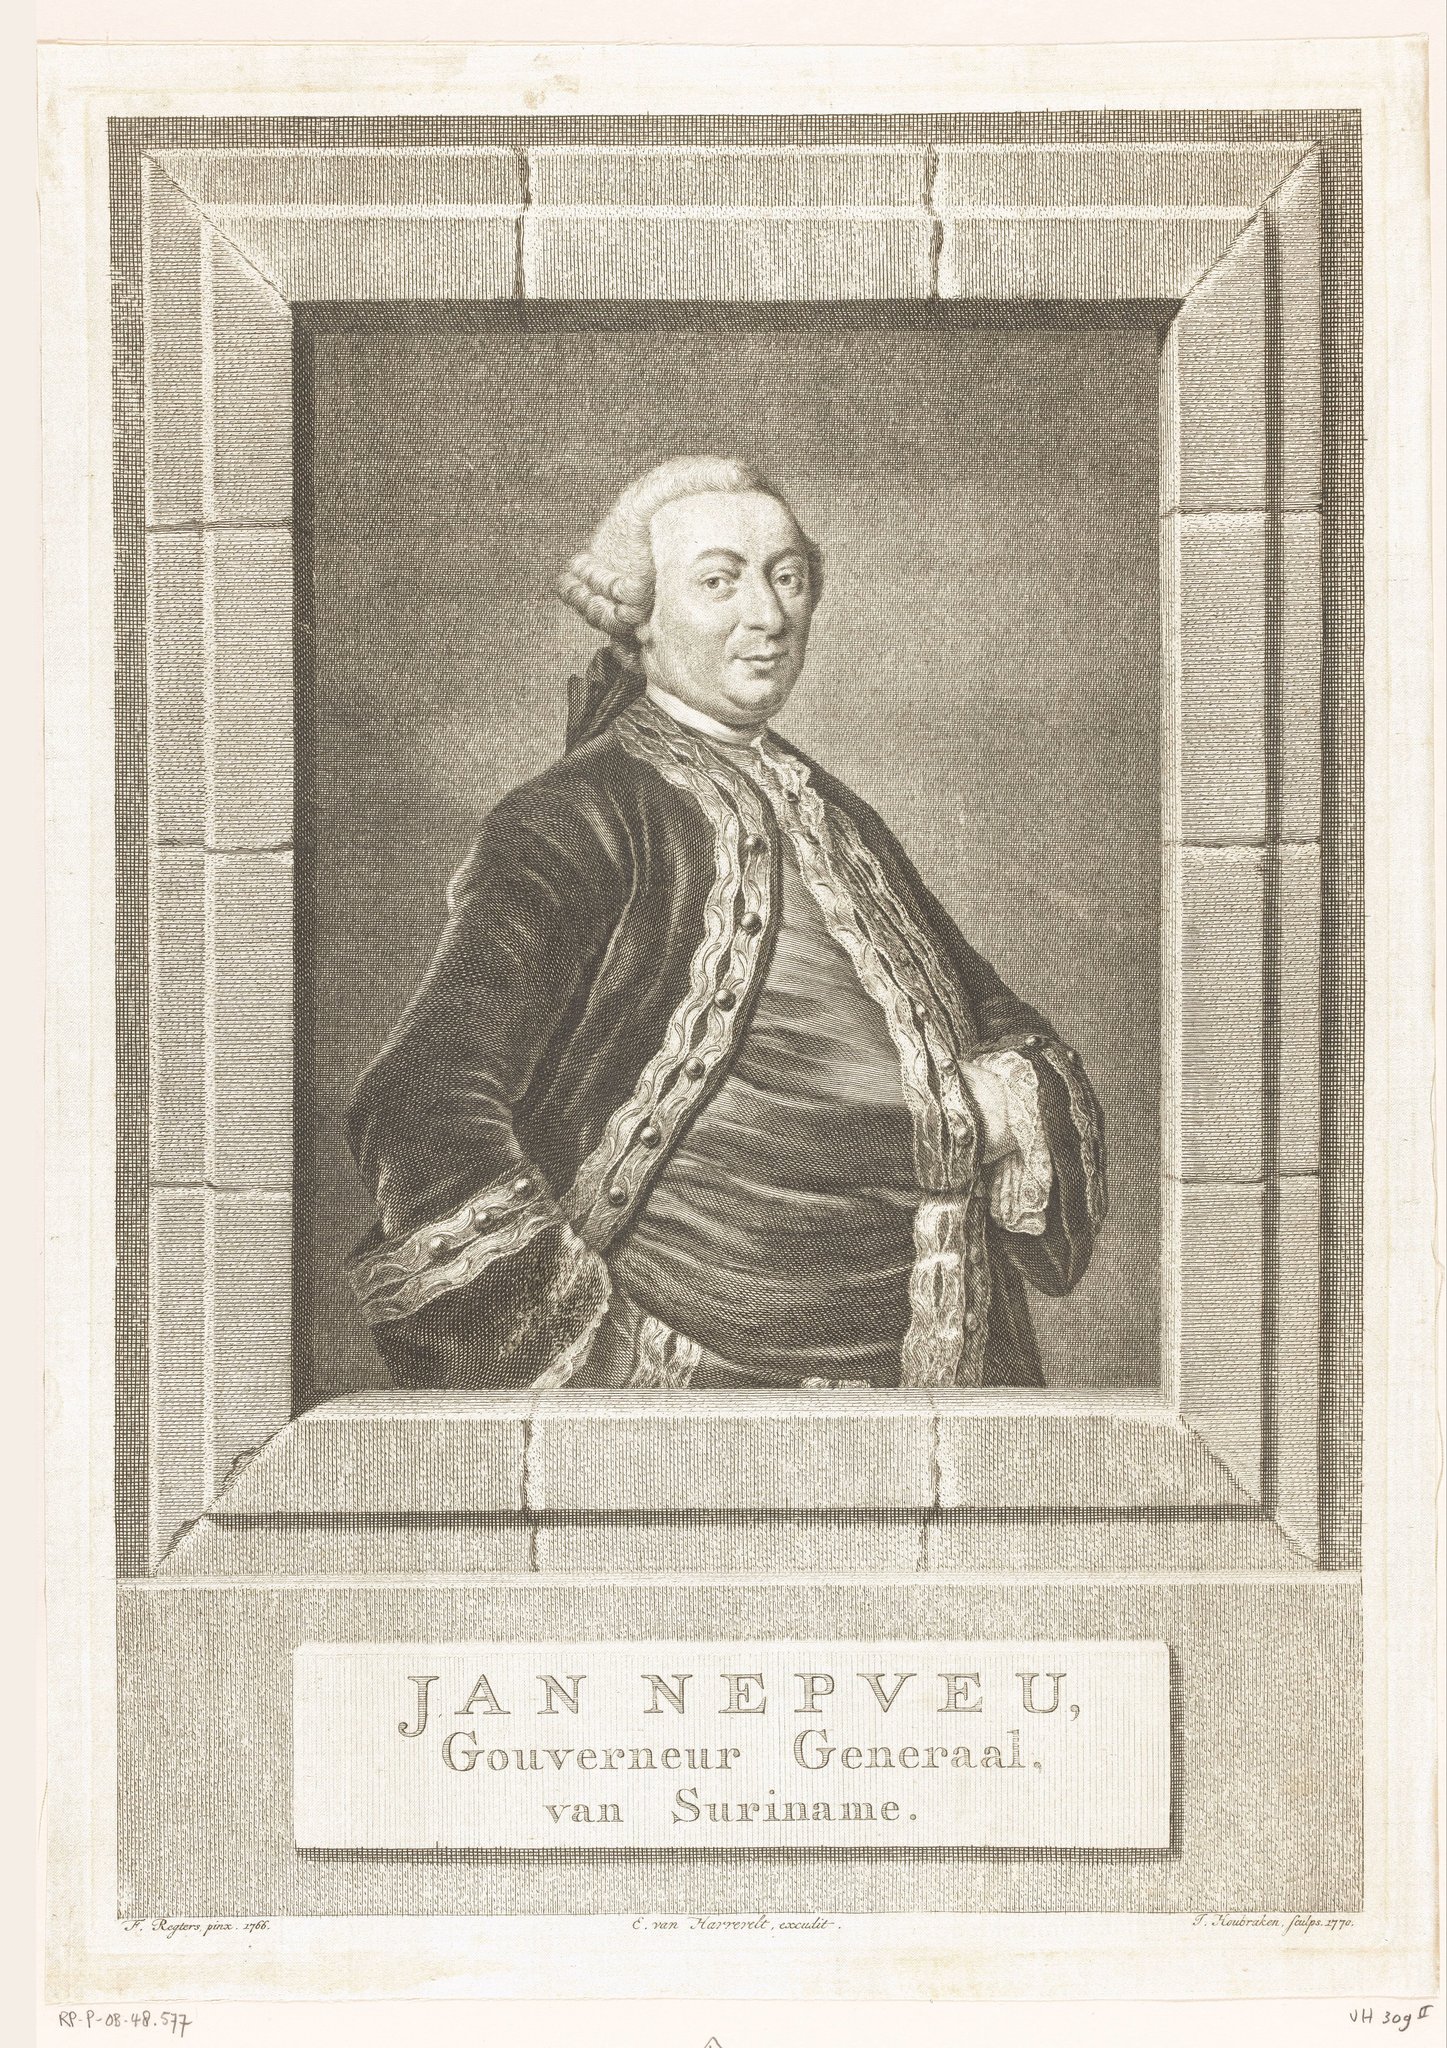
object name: print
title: Portret van Jan Nepveu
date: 1770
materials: silk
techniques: engraving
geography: amsterdam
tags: amsterdam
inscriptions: collector's mark: Lugt 2228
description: Portret ten halven lijve naar rechts van Jan Nepveu in een architectonisch venster. Onder het portret zijn naam en titel in drie regels in het Nederlands.